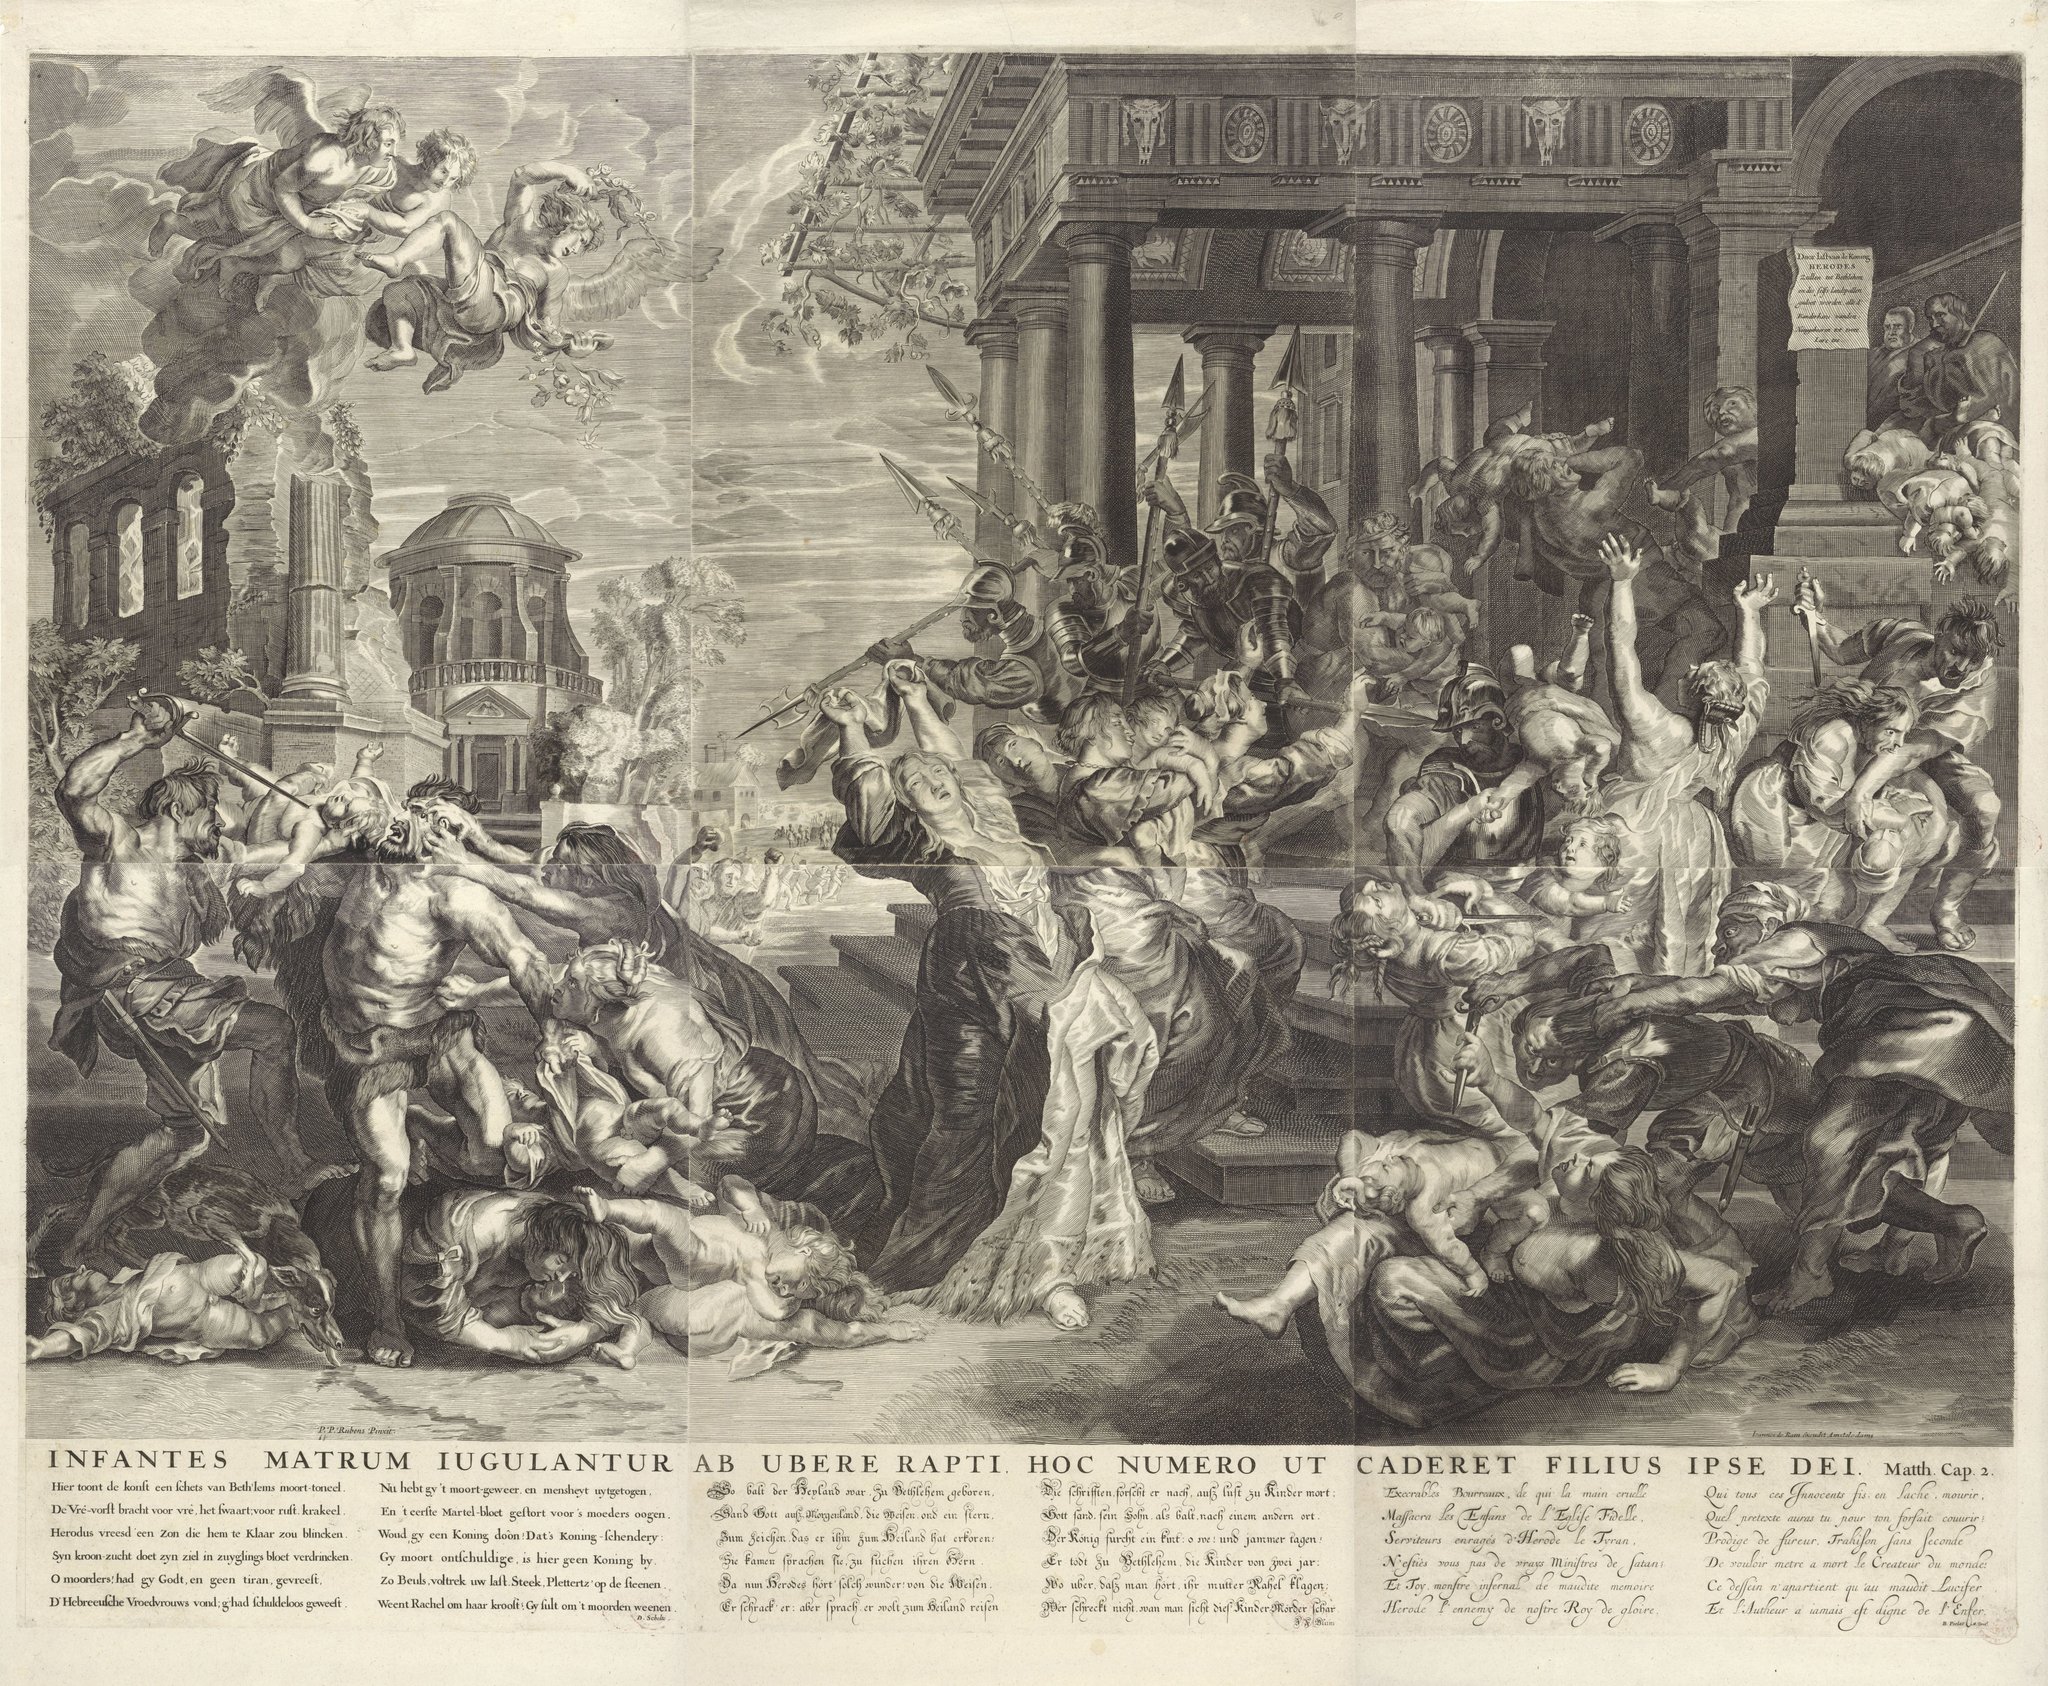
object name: print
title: Kindermoord te Betlehem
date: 1668-1693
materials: paper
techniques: engraving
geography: amsterdam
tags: the massacre of the innocents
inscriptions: collector's mark: Lugt 240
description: Op de binnenplaats van Herodes' paleis te Betlehem proberen moeders hun kinderen te beschermen tegen diens soldaten. Ze rukken de kinderen uit de armen van de wanhopige moeders. De soldaten hebben de opdracht gekregen alle jongens van twee jaar en jonger te vermoorden. Op de zuil hangt een vel papier met dit gebod in het Nederlands. In de marge een Bijbelcitaat uit Mat. 2 in het Latijn. Daaronder een twaalfregelig onderschrift, in twee kolommen, in het Nederlands, Duits en het Frans. Kaart is digitaal samengesteld uit 6 afzonderlijke delen.